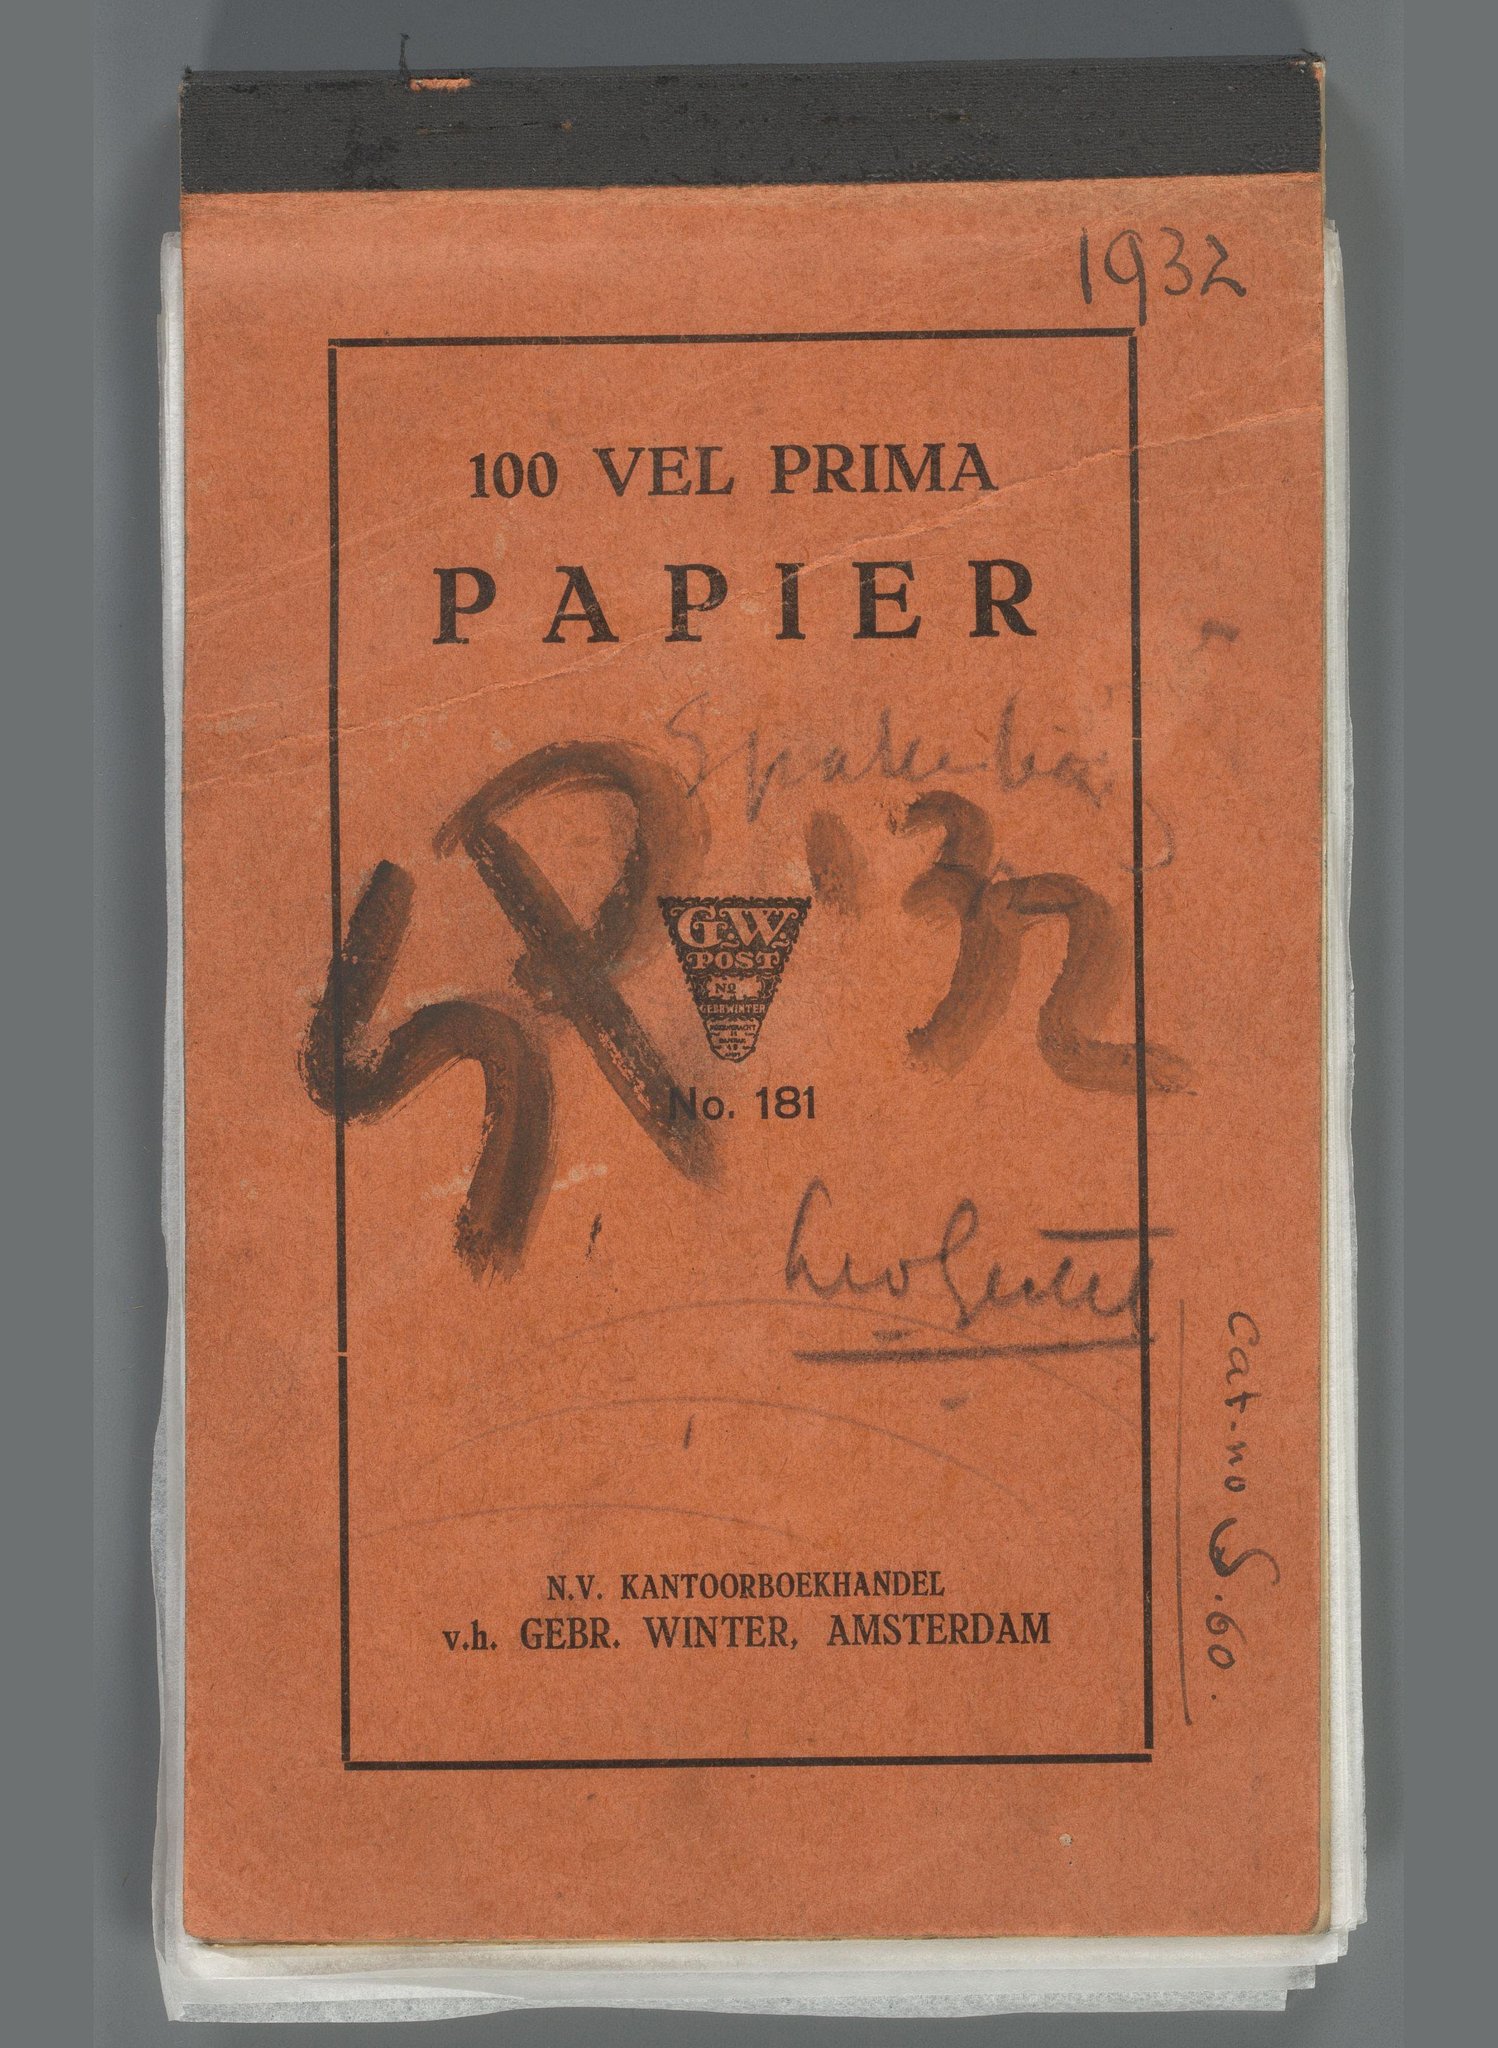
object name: sketchbook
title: Schetsboek Spakenburg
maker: leo gestel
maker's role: draughtsman, print maker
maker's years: 1881-1941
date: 1932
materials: chalk, charcoal, paper, pencil, watercolor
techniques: brush, drawing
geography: spakenburg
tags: spakenburg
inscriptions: signature, date and inscription: ‘Spakenburg '32 Leo Gestel’, inscription: ‘30 bladen 1932’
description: Schetsboek met schetsen van: koppen, dorpsgezichten, haven en figuren.